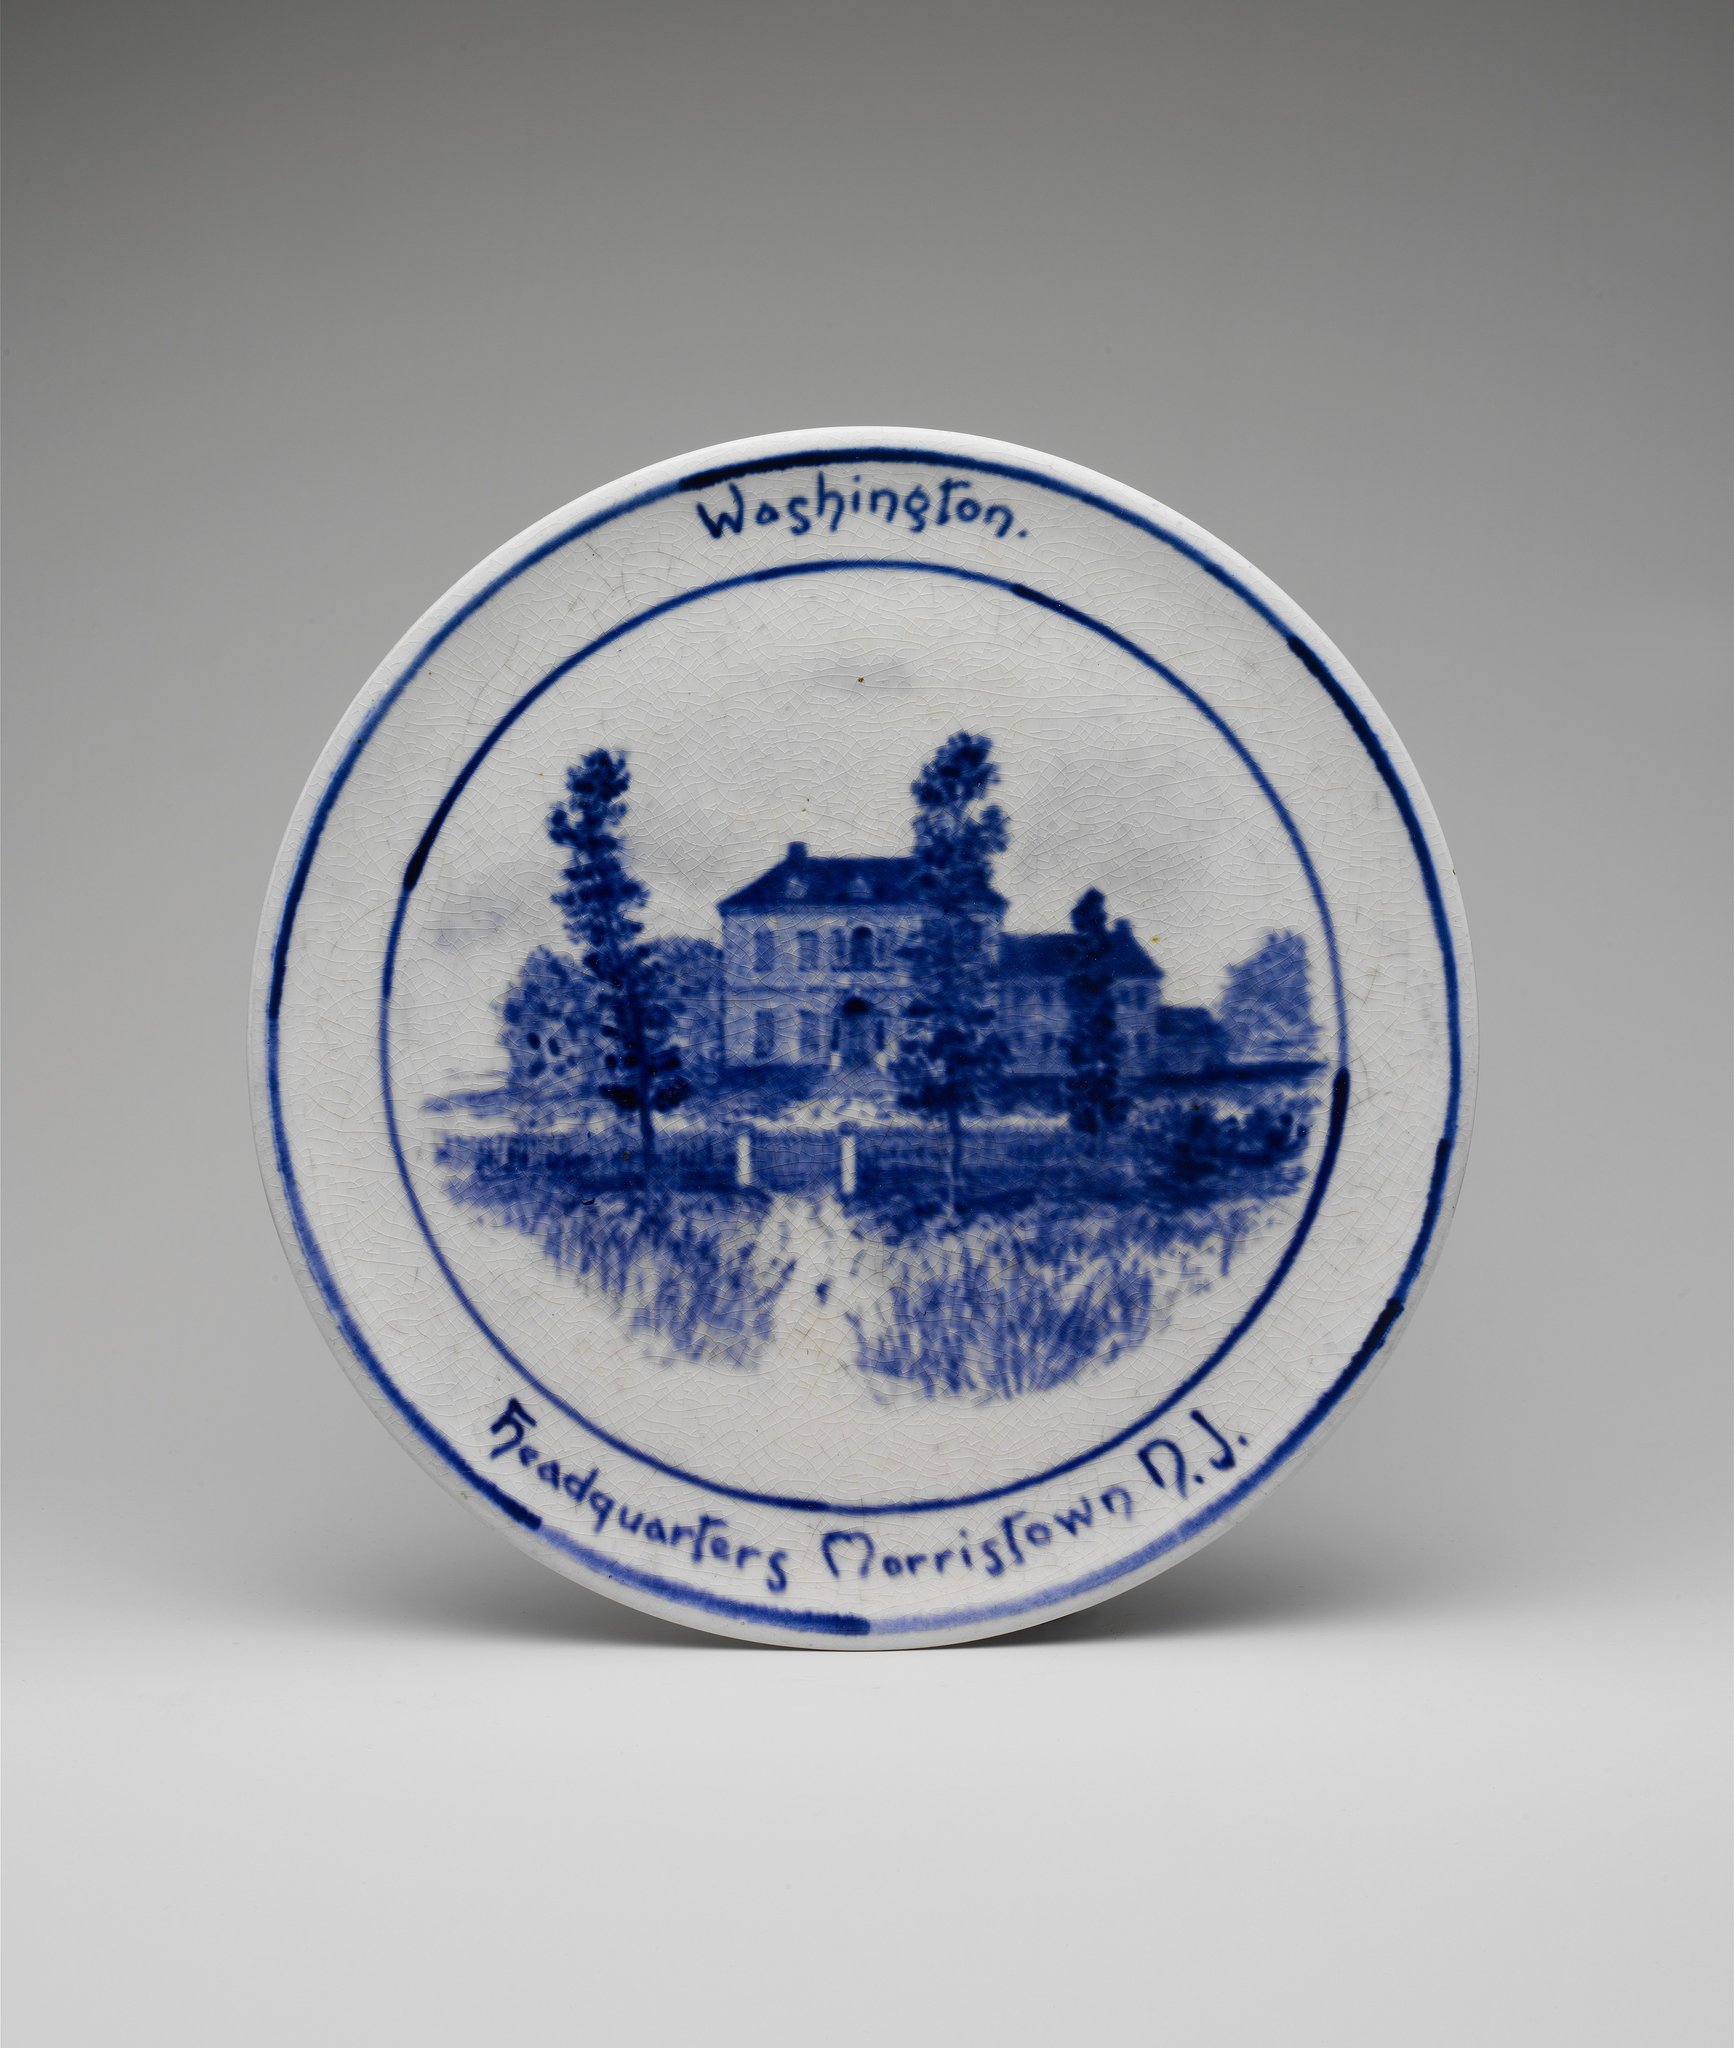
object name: plaque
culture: american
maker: charles volkmar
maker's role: maker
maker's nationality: american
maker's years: 1841-1914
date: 1895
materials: earthenware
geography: united states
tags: houses,trees